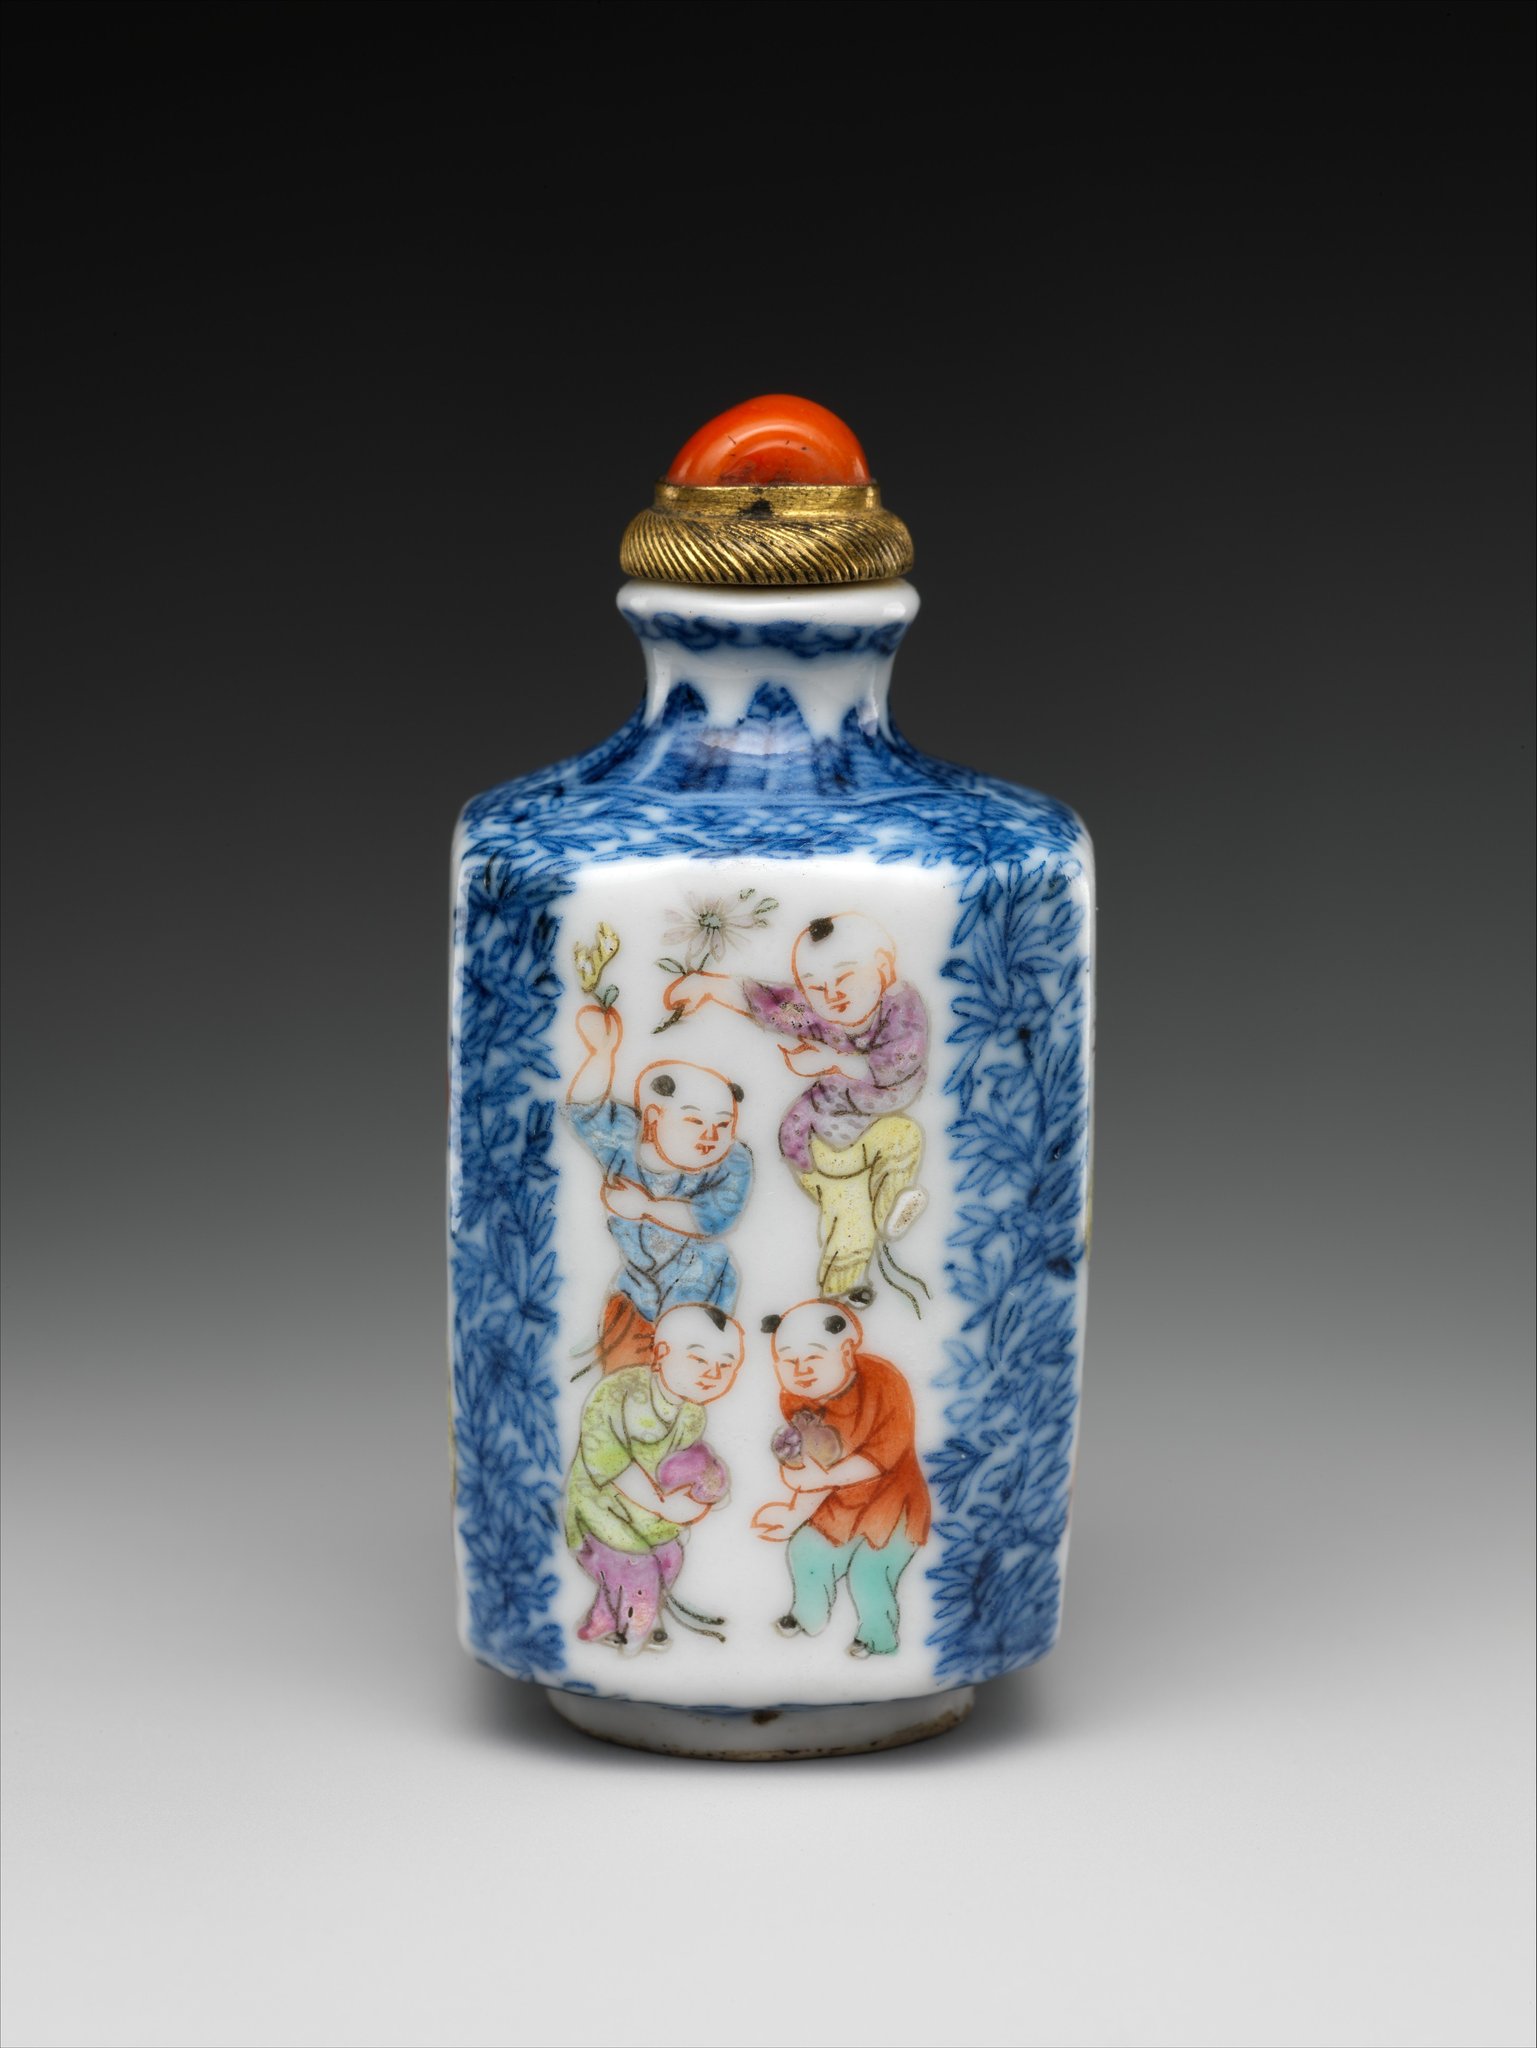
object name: snuff bottle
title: Snuff bottle with boys at play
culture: chinese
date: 1821-1850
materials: cobalt, coral, enamel, metal, porcelain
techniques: overglaze, painting, underglaze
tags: boys,playing